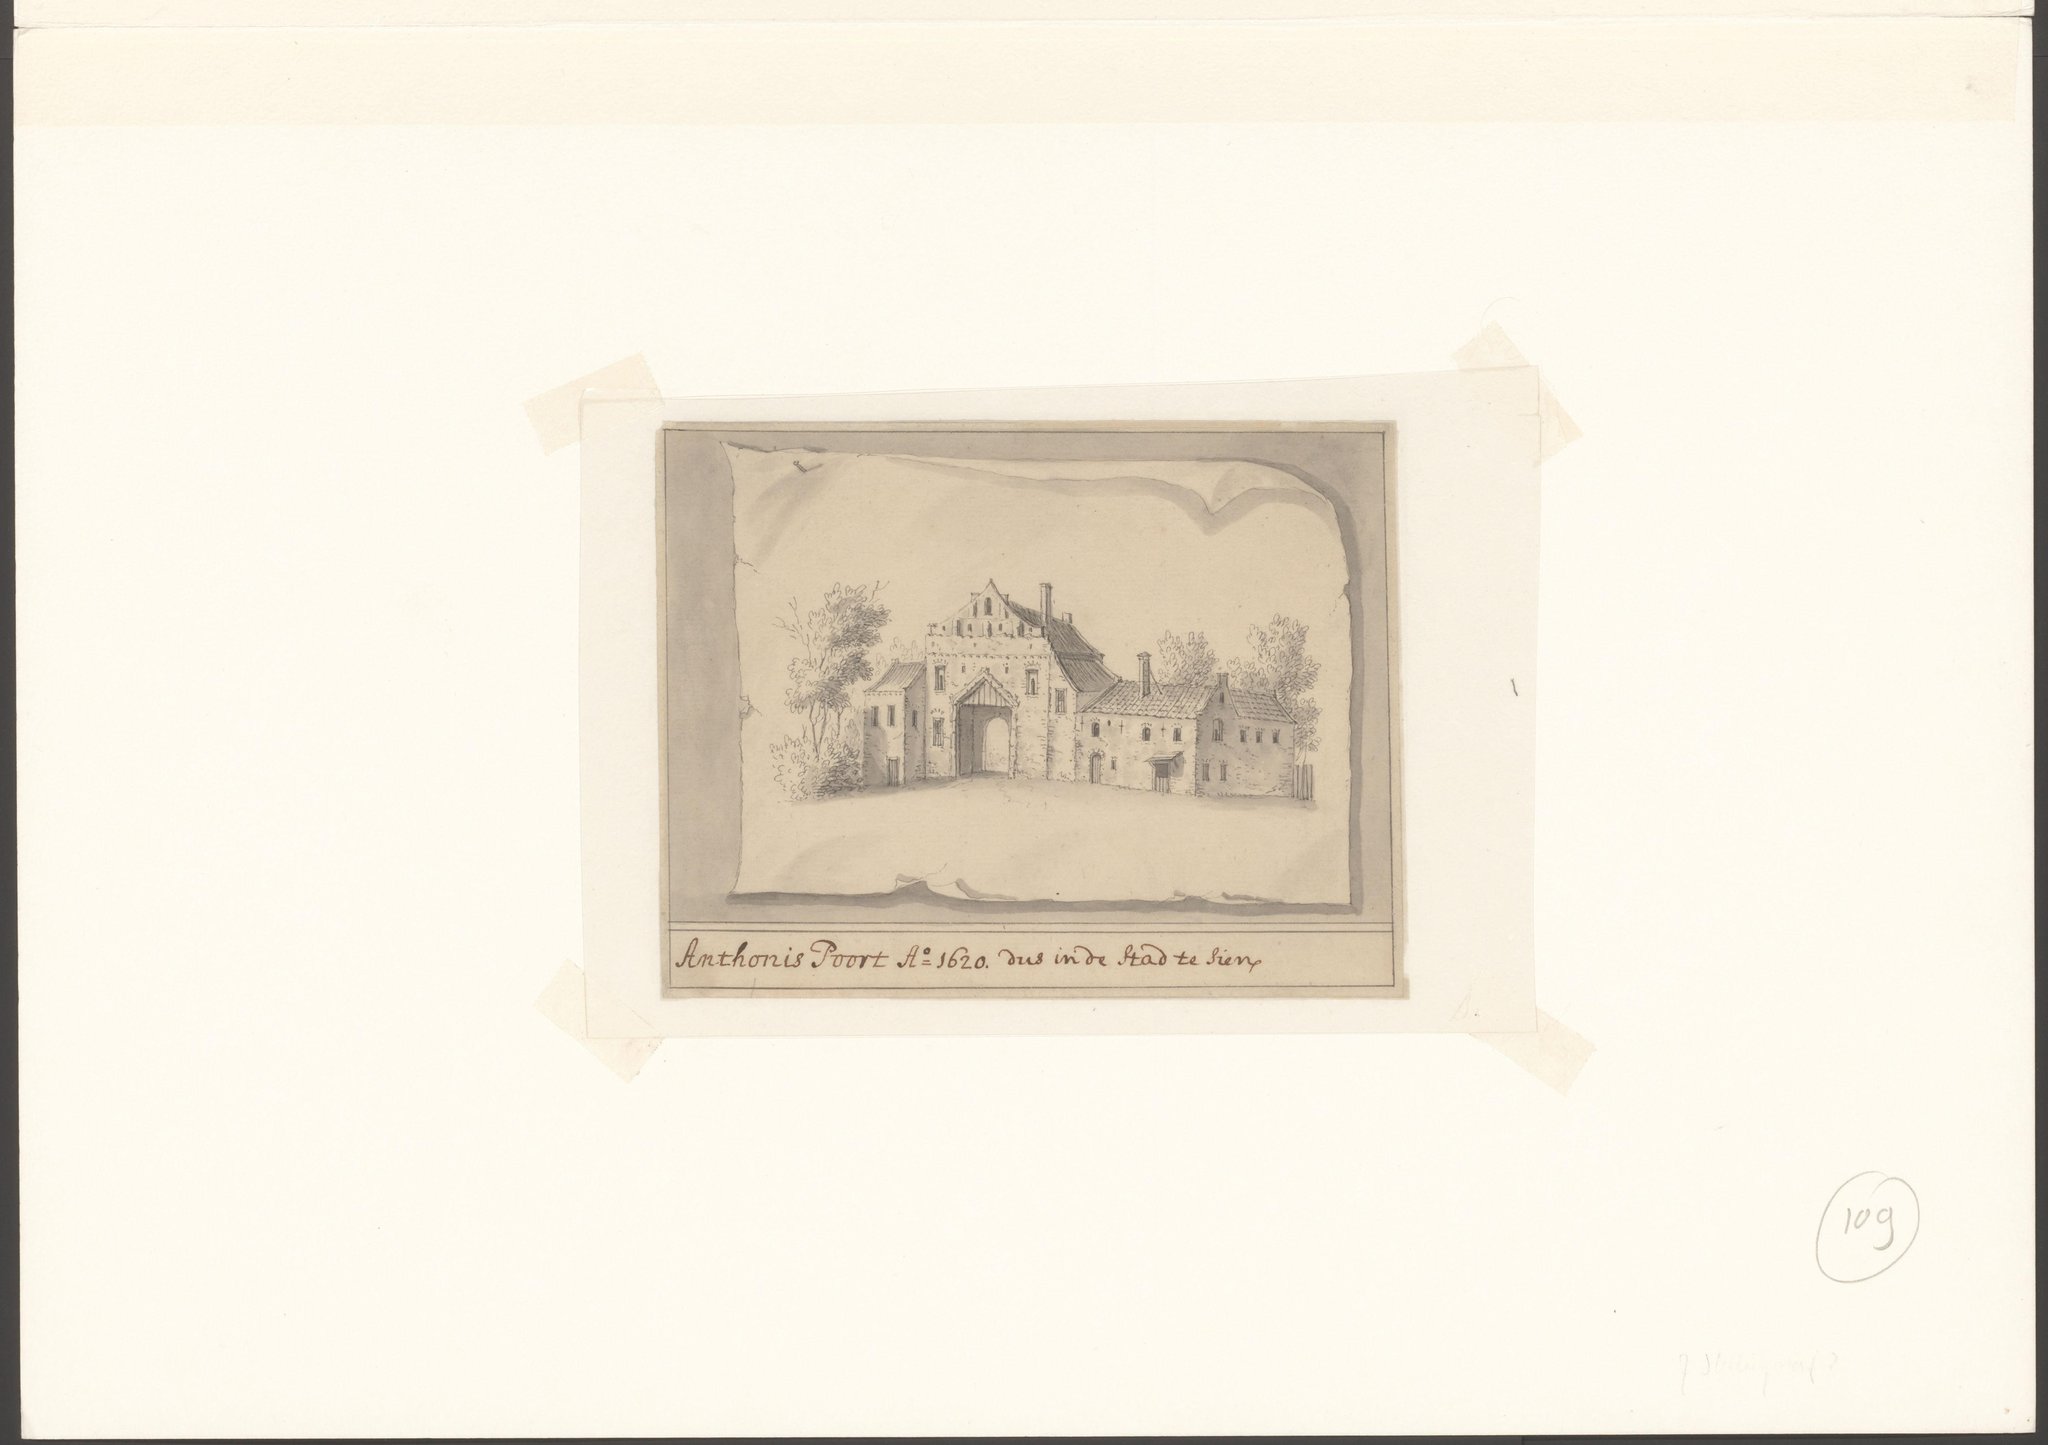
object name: drawing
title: Gezicht op de Sint Anthoniespoort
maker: antonina houbraken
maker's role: draughtsman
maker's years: 1696-1736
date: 1706-1736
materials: ink, paper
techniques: brush, pen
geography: amsterdam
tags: city-view in general; 'veduta', city-gate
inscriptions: inscription: ‘Anthonis Poort Ao 1620. dus in de stad te sien’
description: Onderwerpsrubriek binnen de Atlas Amsterdam: St. Antoniespoort.